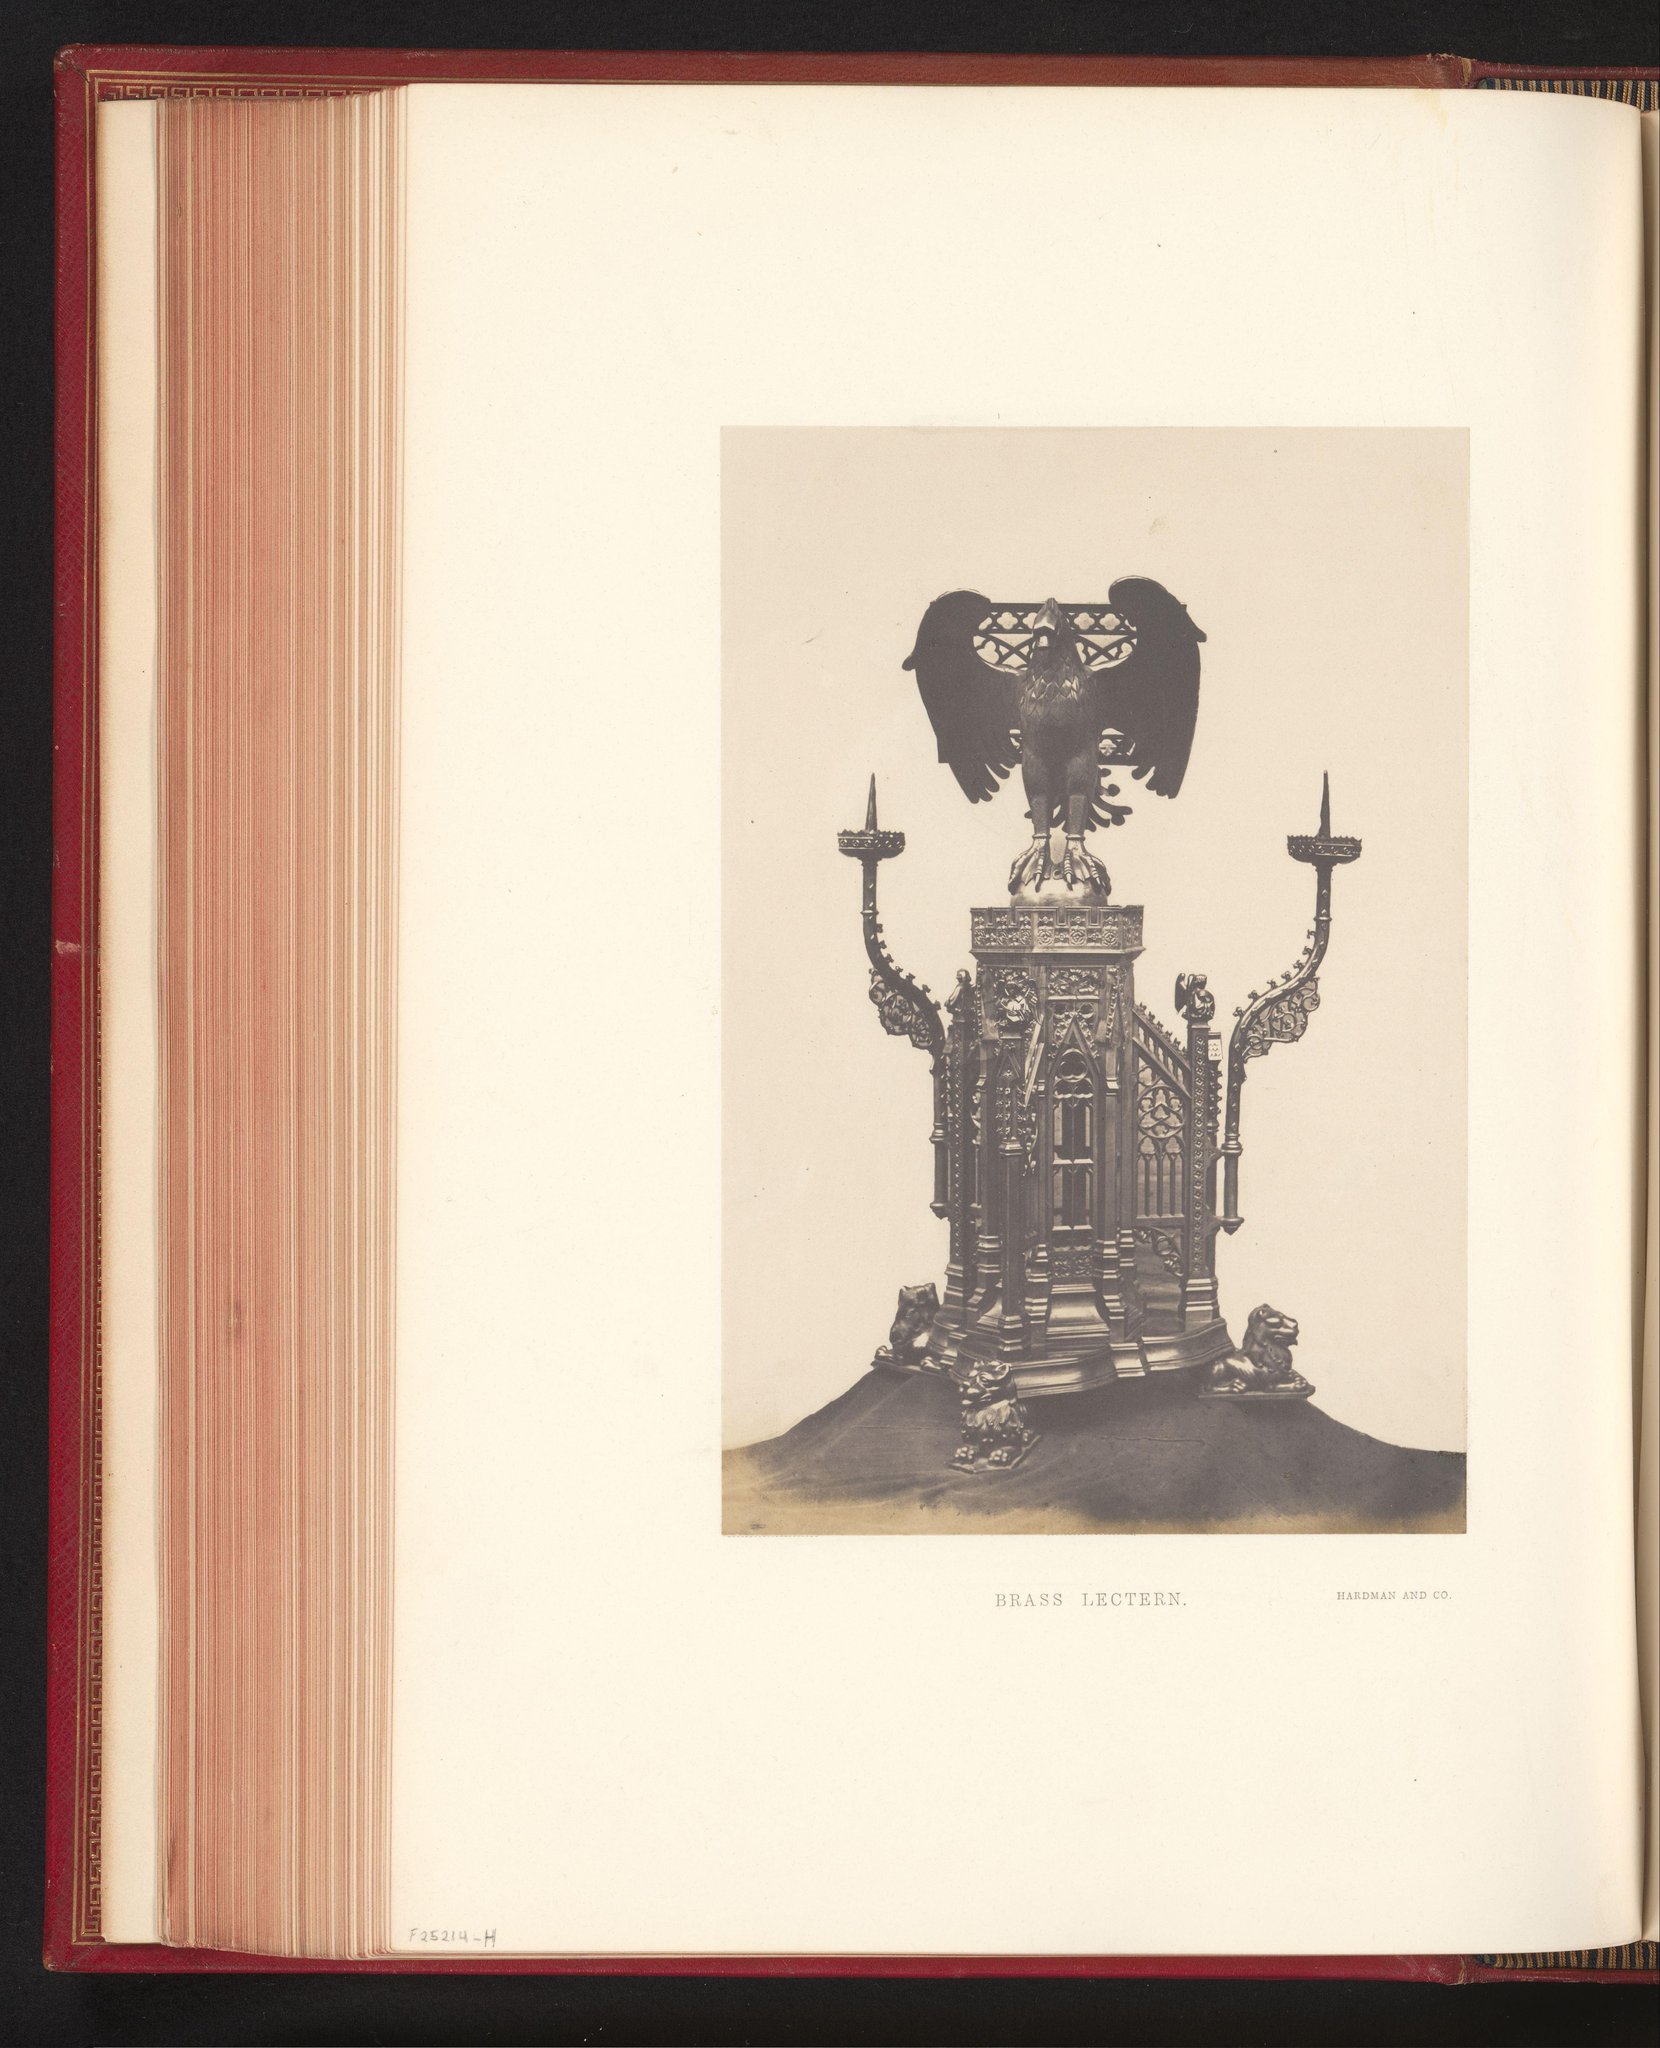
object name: photograph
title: Brass Lectern. Hardman and Co.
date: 1851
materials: photographic support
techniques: salted paper print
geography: london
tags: lectern, london